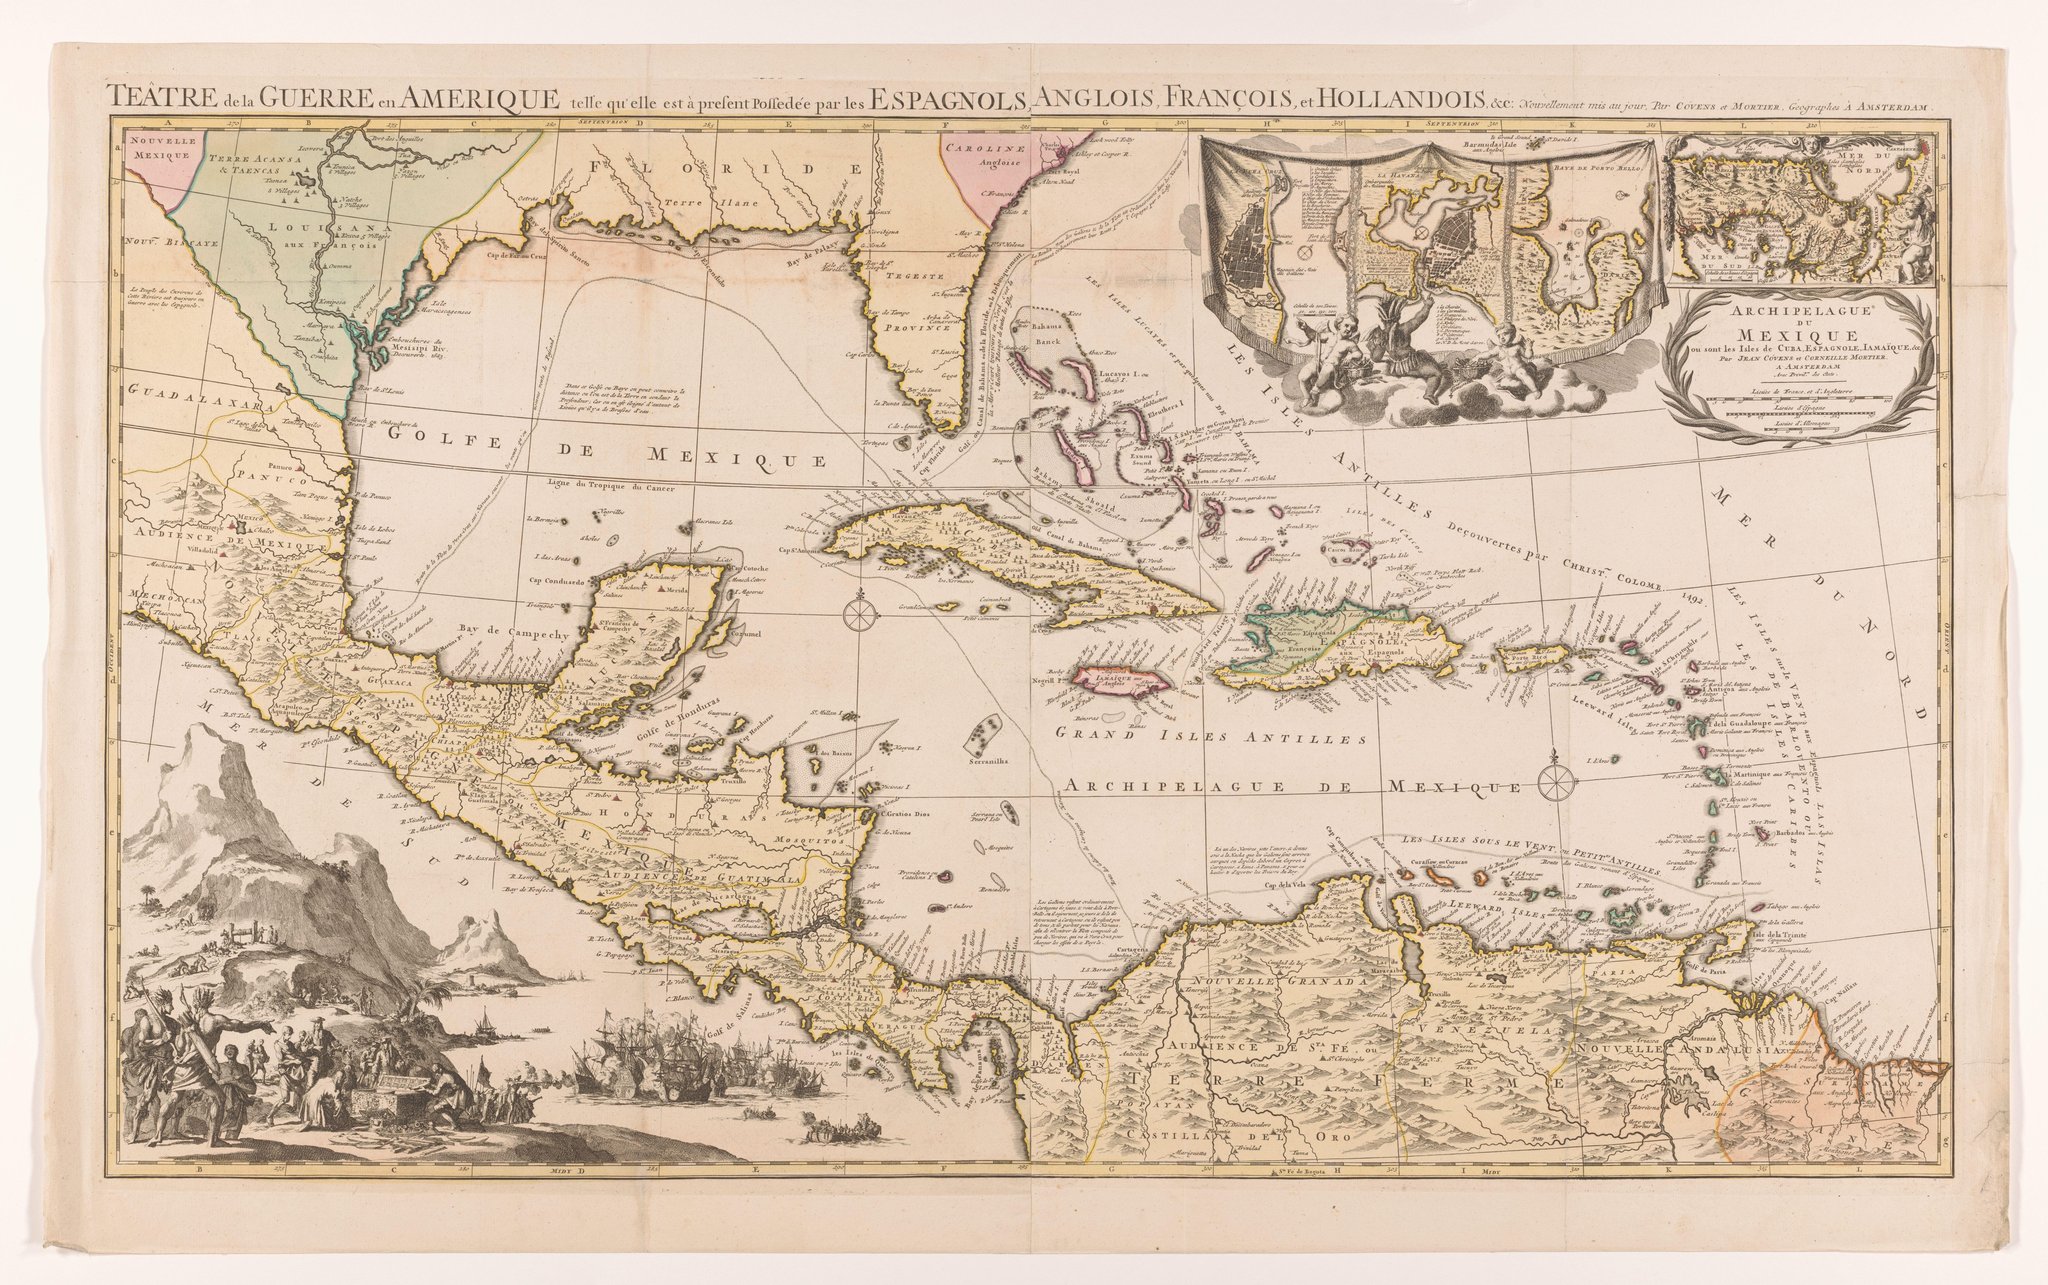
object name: print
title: Teatre de la guerre en Amerique telle qu'elle est à possedée (...) / Archipelague du Mexique ou sont les isles de Cuba, Espagnole (...)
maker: Anonymous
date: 1727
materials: paper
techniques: engraving, etching, hand coloring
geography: amsterdam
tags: imperialism, maps of separate countries or regions, maps of cities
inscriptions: inscription